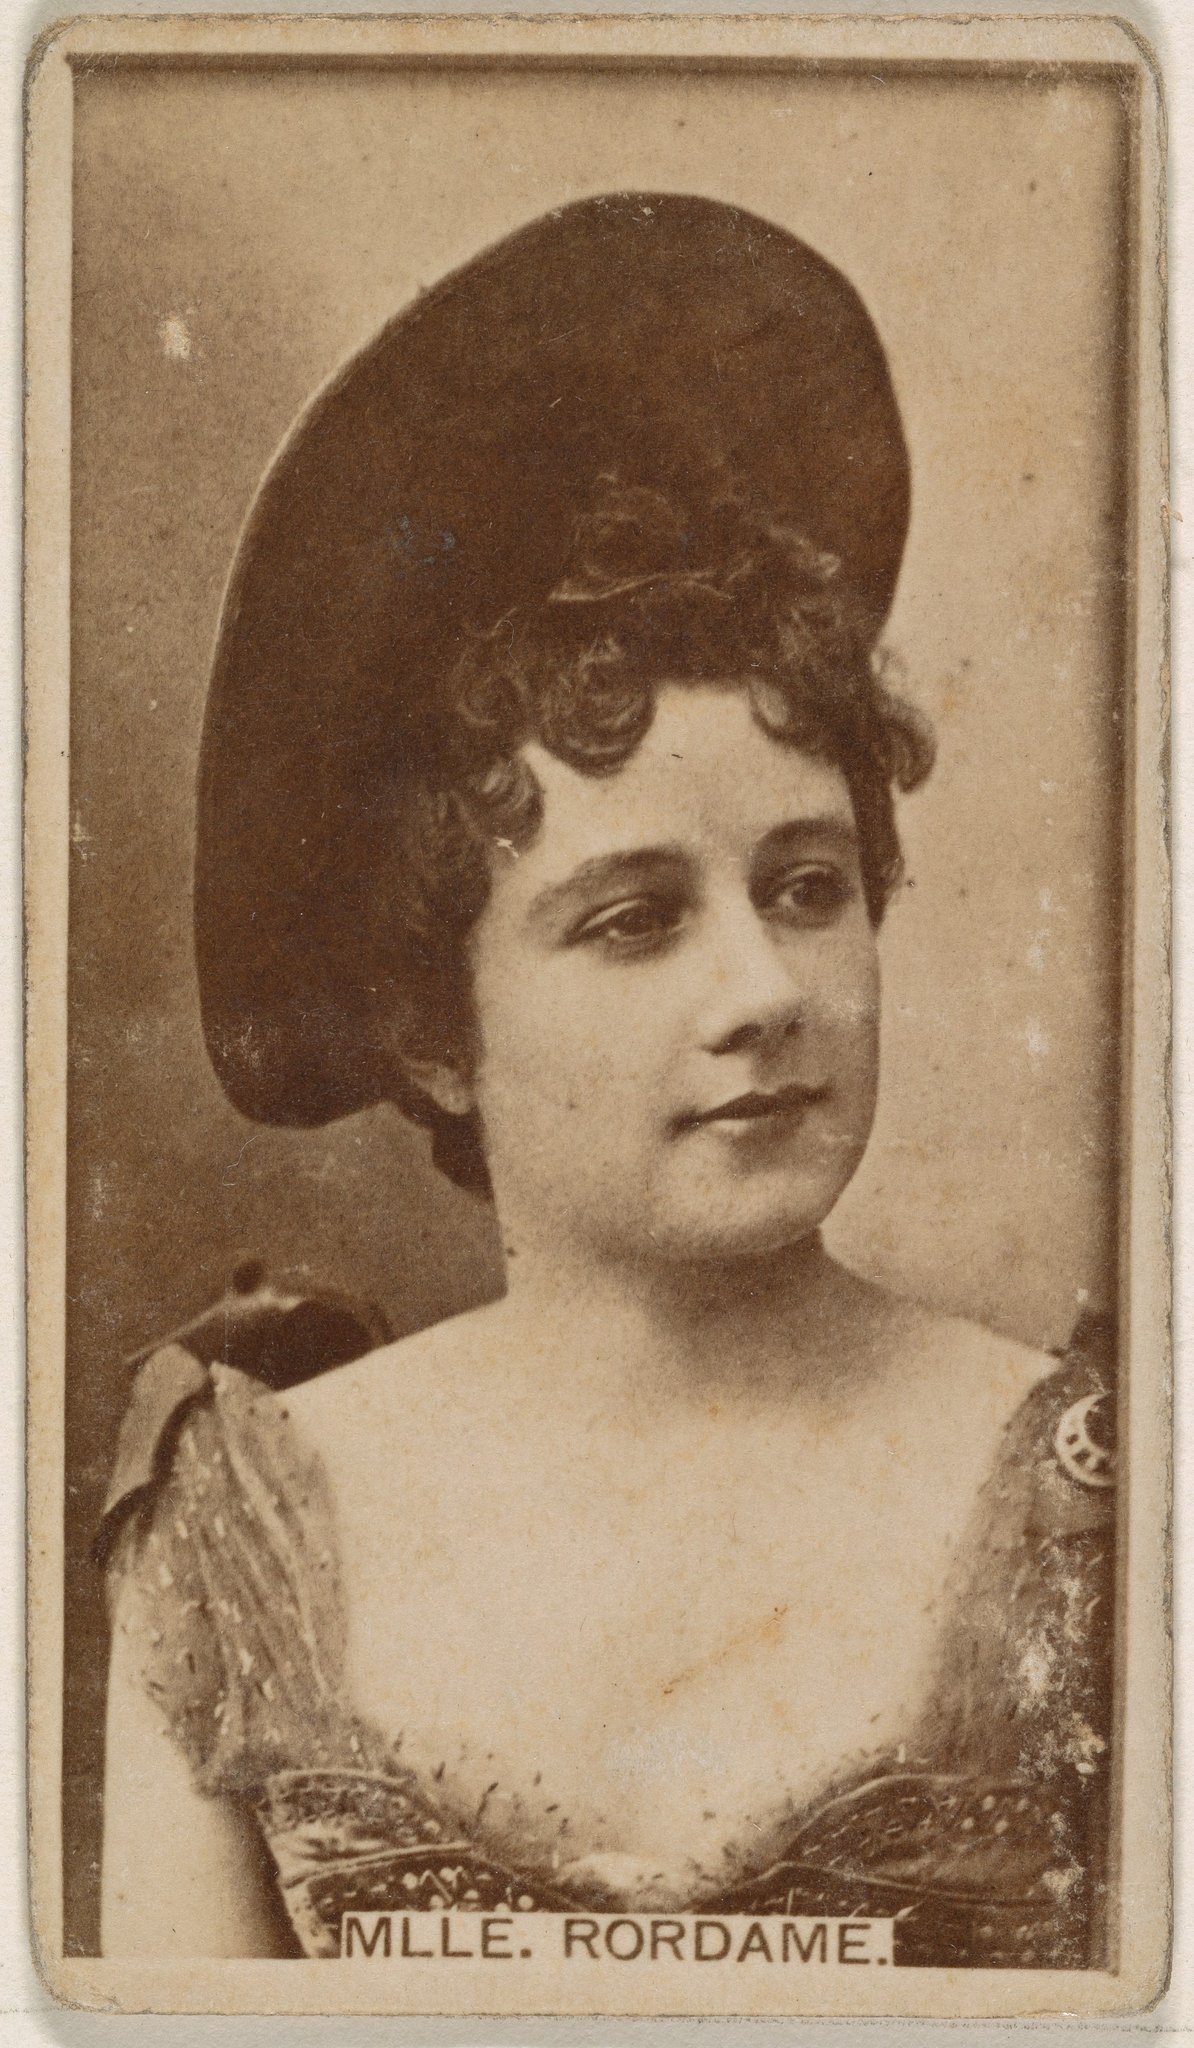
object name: photograph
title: Mlle Rordame, from the Actresses series (N245) issued by Kinney Brothers to promote Sweet Caporal Cigarettes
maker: kinney brothers tobacco company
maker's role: publisher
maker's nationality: american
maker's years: 1869-2011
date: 1890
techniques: albumen silver print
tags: portraits,women,actresses